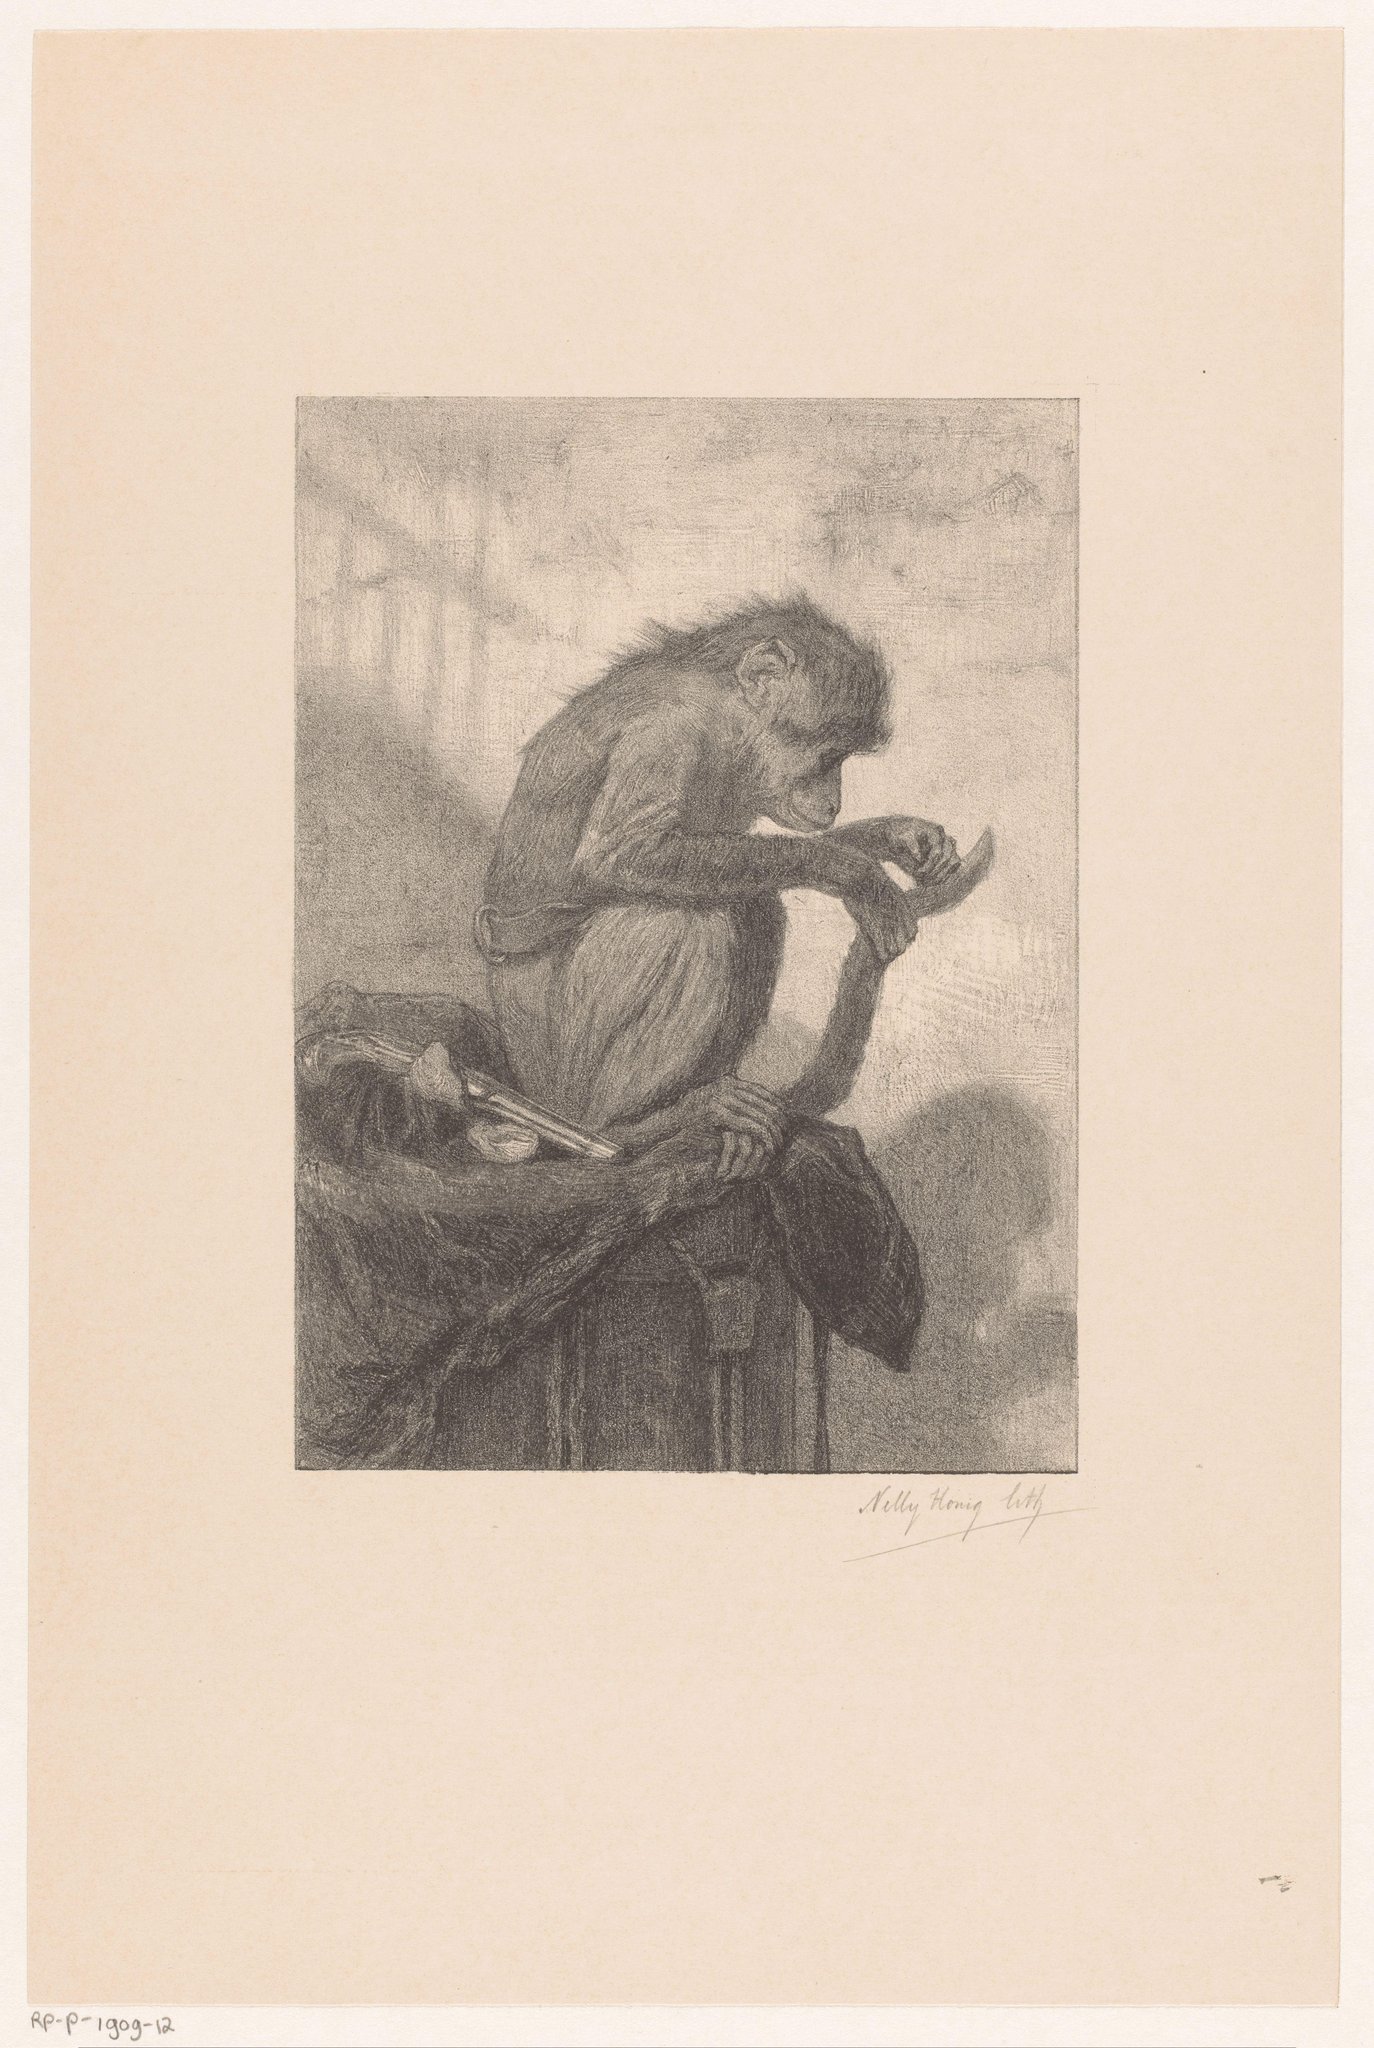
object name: print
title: Het toilet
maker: nellie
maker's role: print maker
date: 1892-1909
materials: paper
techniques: lithograph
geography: netherlands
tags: monkeys, apes, looking for fleas, firearms (with name), earning money with monkey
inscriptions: signature: ‘Nelly Honig Lith’, collector's mark: Lugt 2228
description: Het schilderij uit 1881 werd door ene Walter in prent gebracht, een houtgravure, en in 1892 uitgegeven in Eigen Haard (No. 49, p. 773).